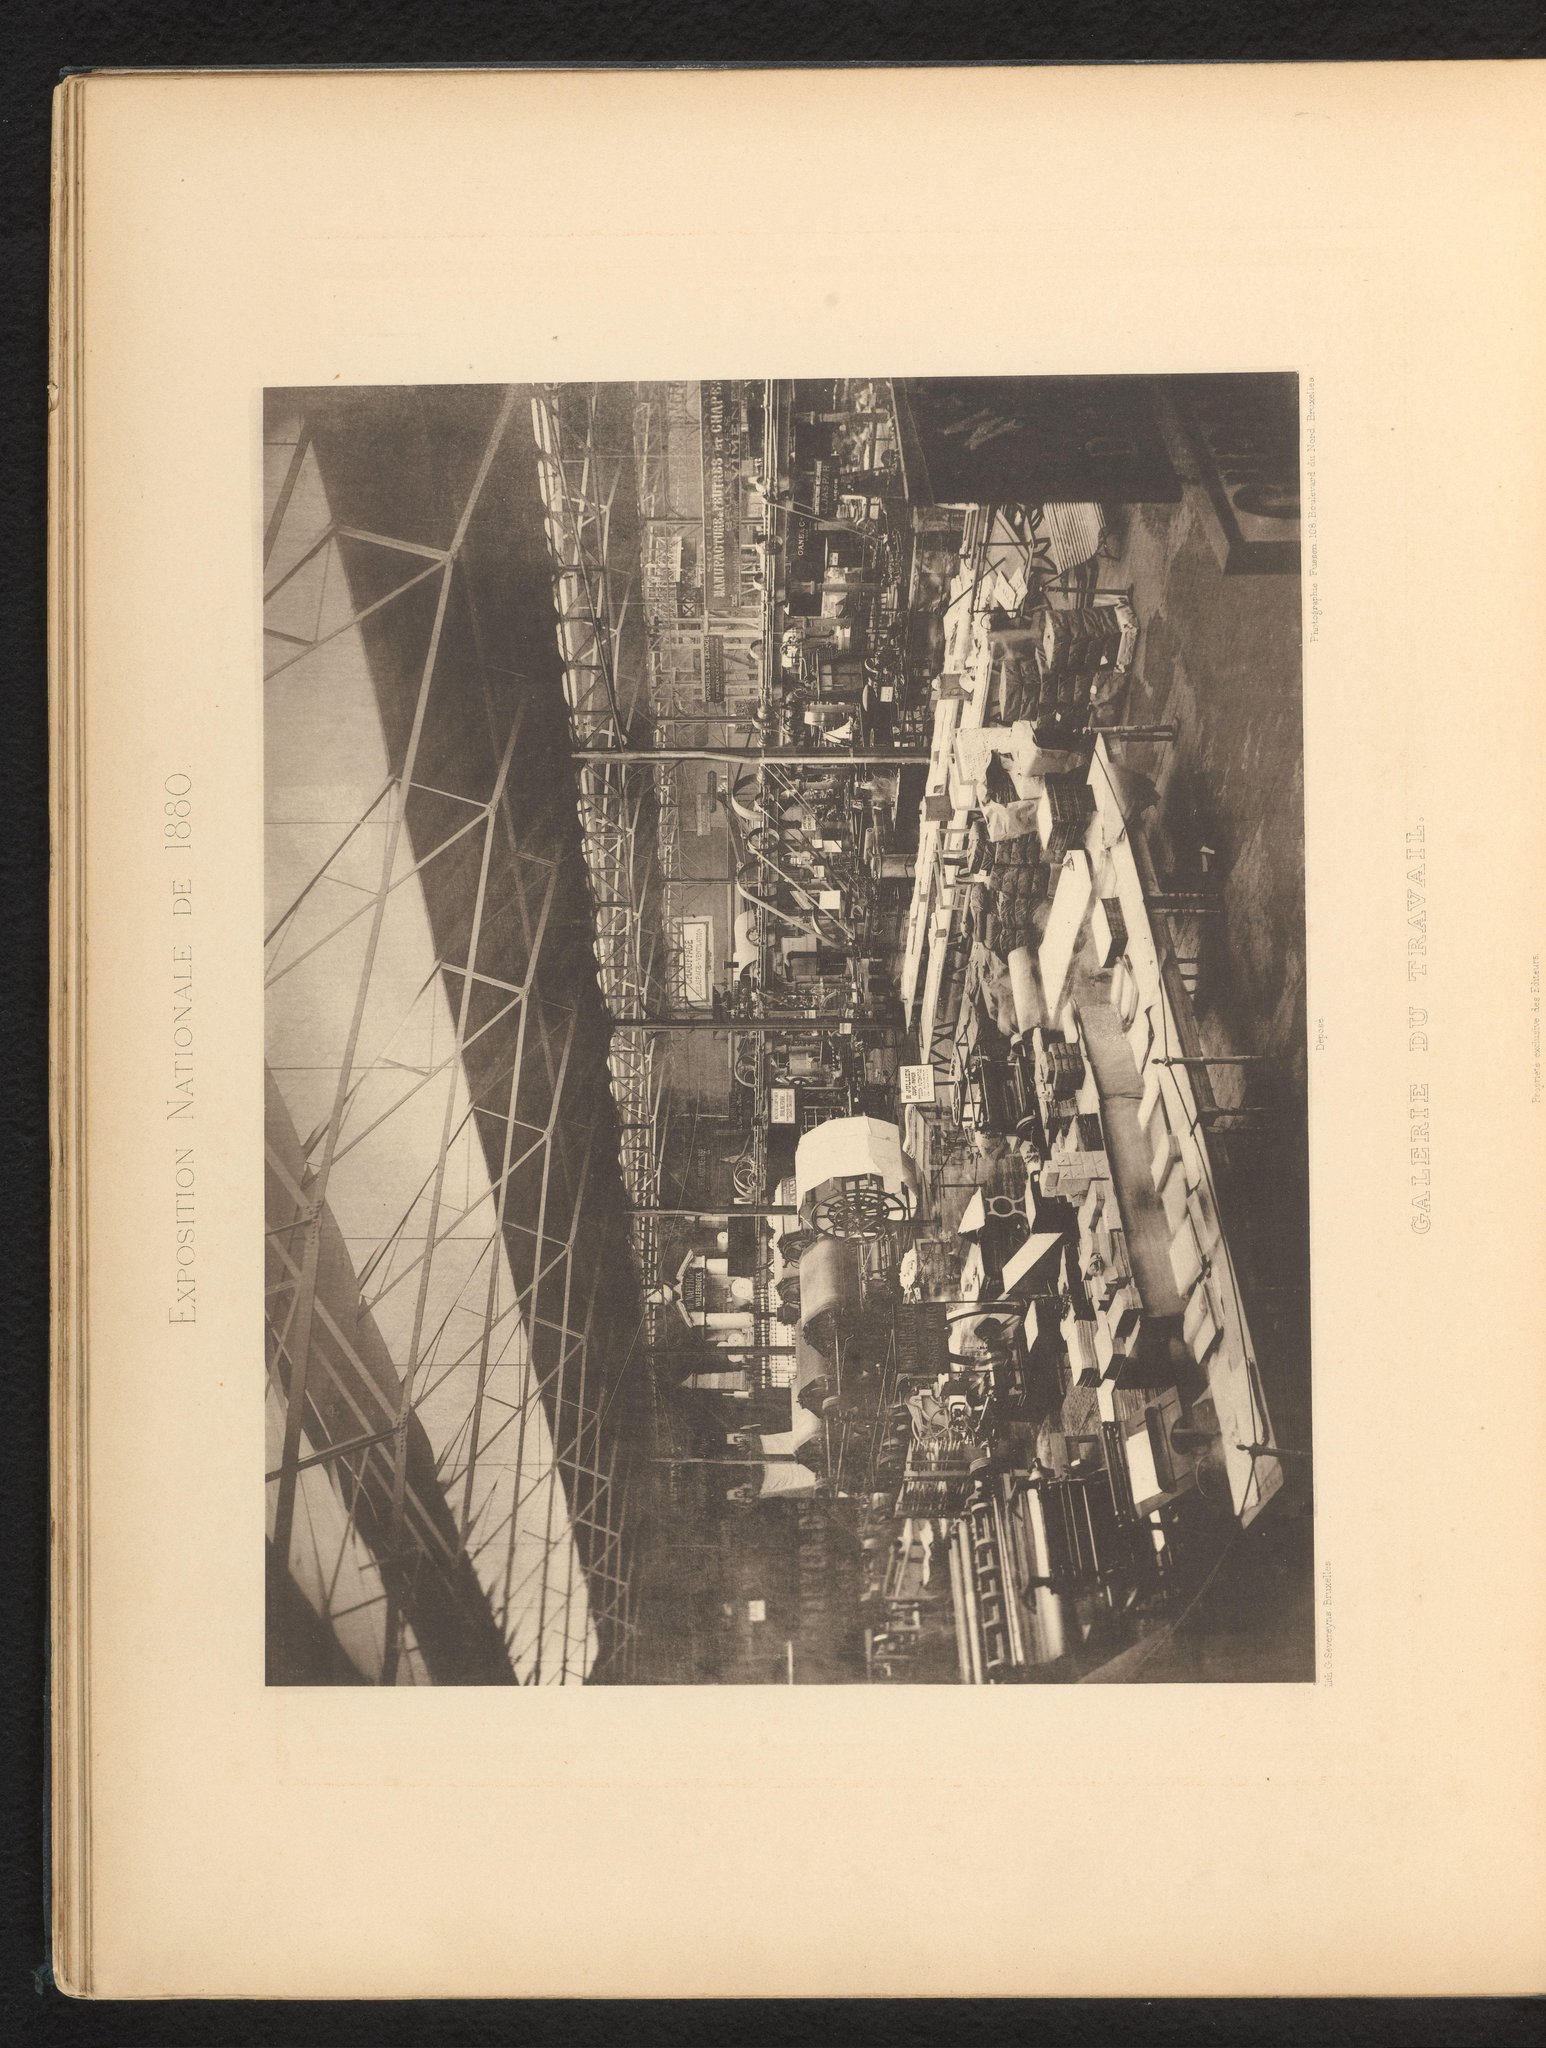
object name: photomechanical print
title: Galerie du Travail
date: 1880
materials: paper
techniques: photograph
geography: brussels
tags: trade exhibition, industries fair, brussels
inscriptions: address: ‘Photographie Fussen, 108, Boulevard du Nord, Bruxelles.’, inscription: ‘Déposé.’, inscription: ‘Proprieté exclusive des Editeurs.’